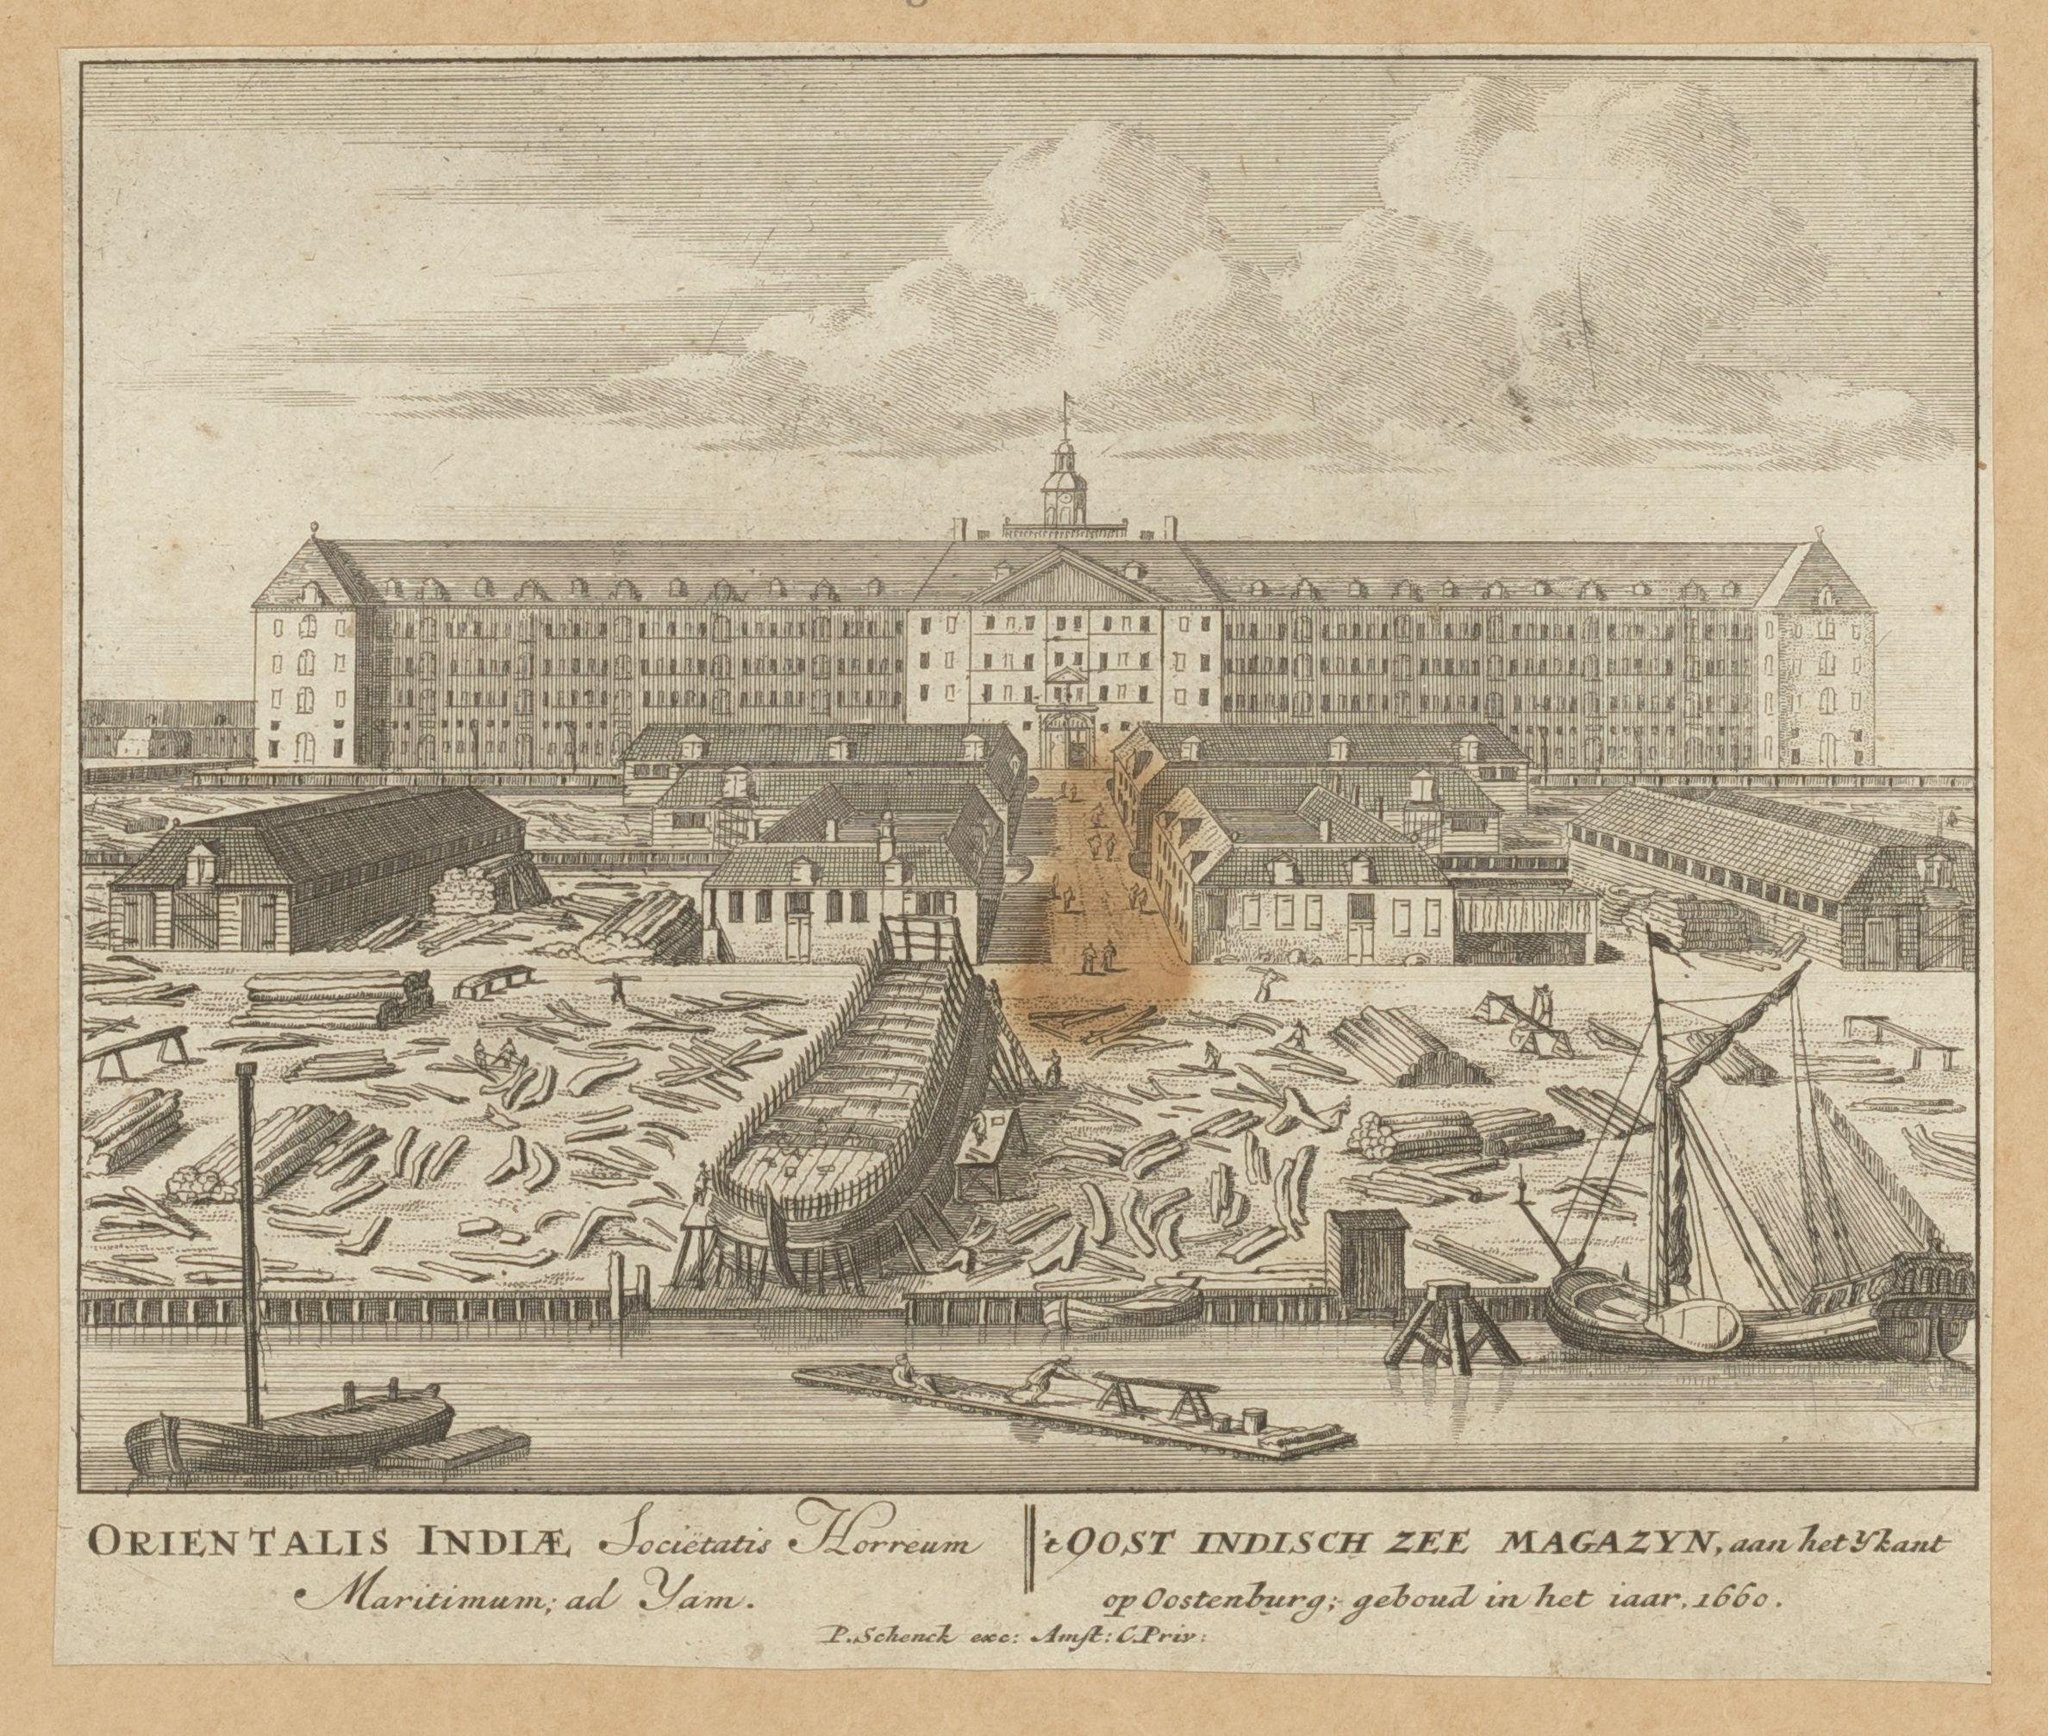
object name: print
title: 't Oost Indisch Zee Magazyn, aan het Ykant op Oostenburg; geboud in het iaar 1660 / Orientalis Indiae Sociëtatis Horreum Maritimum; ad Yam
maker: Anonymous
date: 1710-1711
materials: paper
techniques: engraving, etching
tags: large-scale structure for storage, e.g.: warehouse, depot, silo, trade-company, building a ship, ship under construction, shipyard, shipdock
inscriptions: stamp, collector's mark: Lugt 1641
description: Genummerde staat van prent ook gebruikt in: 100 Afbeeldinge der voornaamste gebouwen van Amsterdam. Amsterdam, Pieter Schenk (I), s.a. [1710-1711]. En in: 100 Afbeeldinge der voornaamste gebouwen van Amsterdam. Amsterdam: Barent Greve, s.a. [1757-1766].* *In de tweede uitgave, uitgegeven door Barent Greve, is alleen de titelprent aangepast. De overige prenten zijn onveranderd gebleven.